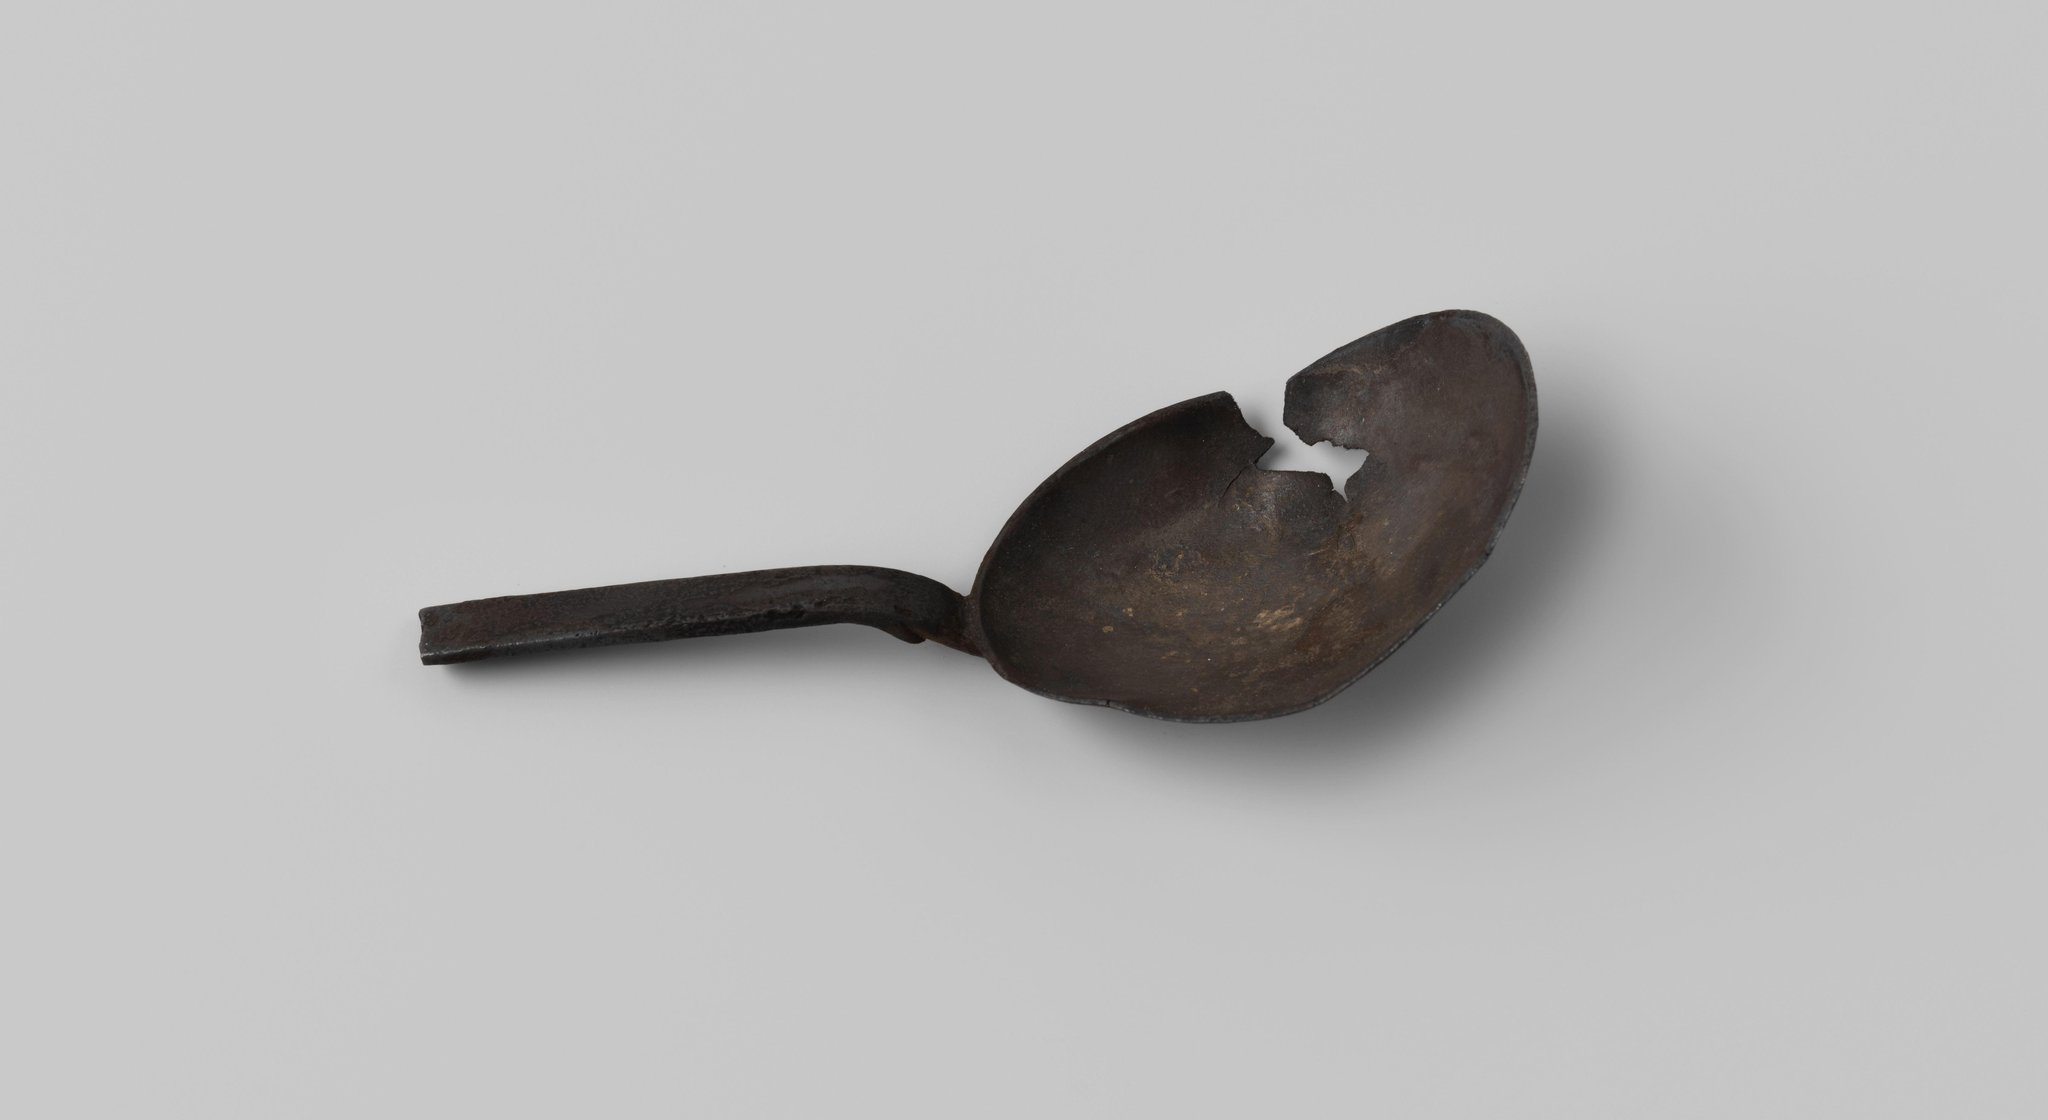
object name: spoon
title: Lepel uit het wrak van de Oost-Indiëvaarder Princesse Maria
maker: Anonymous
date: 1670-1686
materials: silver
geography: netherlands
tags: princesse maria (schip), verenigde oostindische compagnie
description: Zilveren lepel met stuk steel, de lepel zelf is gebarsten. Op de bolle zijde van de (ovalen) lepel is deze gemerkt.